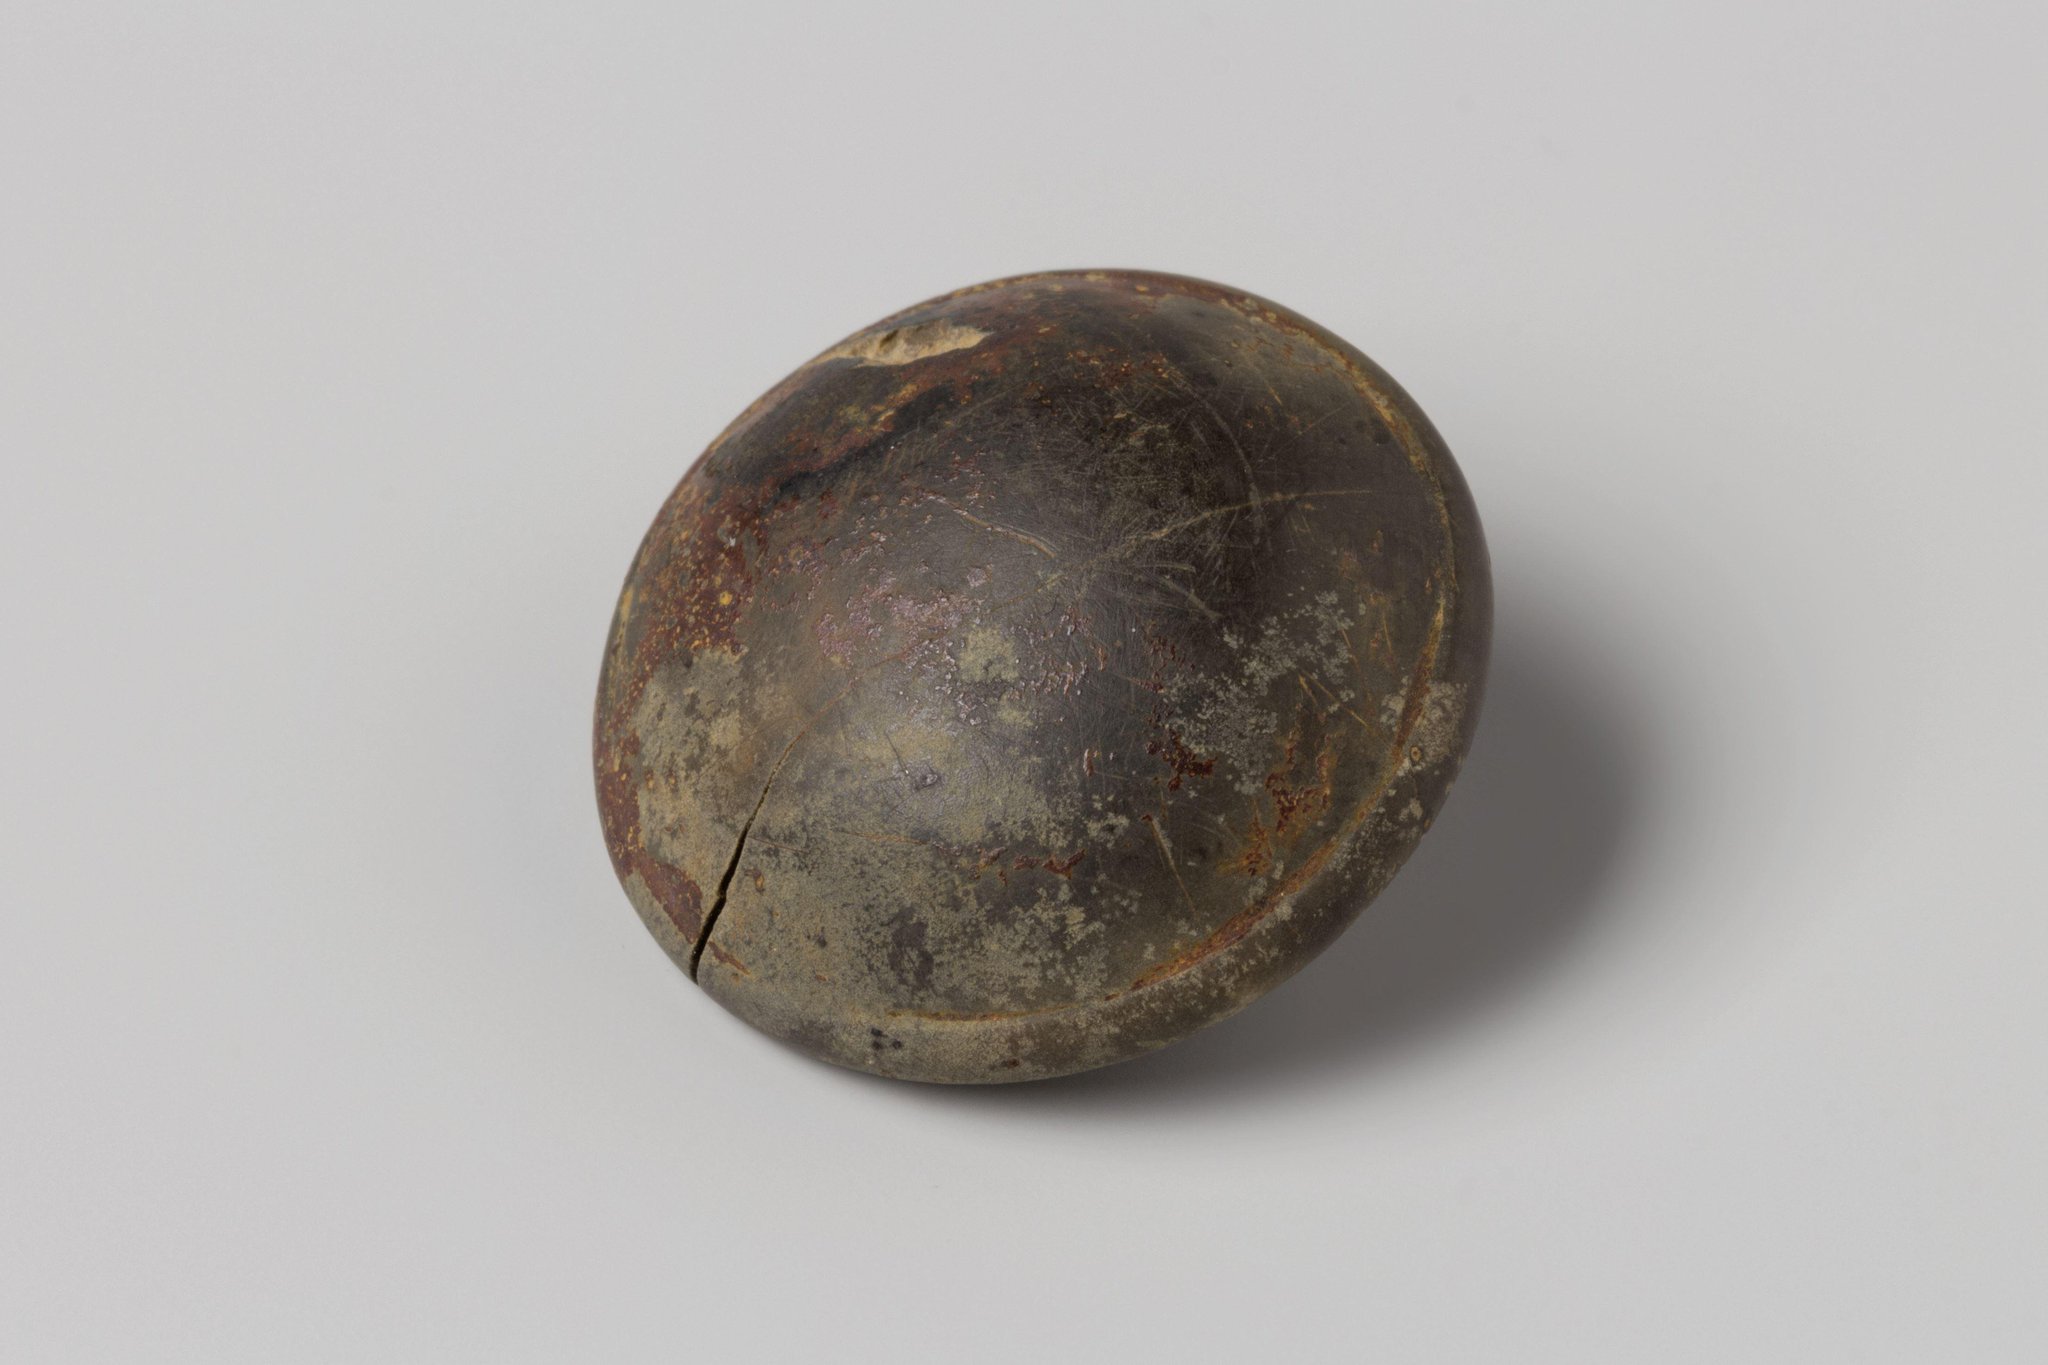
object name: button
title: Knoop uit het wrak van de Oost-Indiëvaarder Hollandia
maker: Anonymous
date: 1700-1743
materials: bone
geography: netherlands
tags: verenigde oostindische compagnie, hollandia (schip), annet